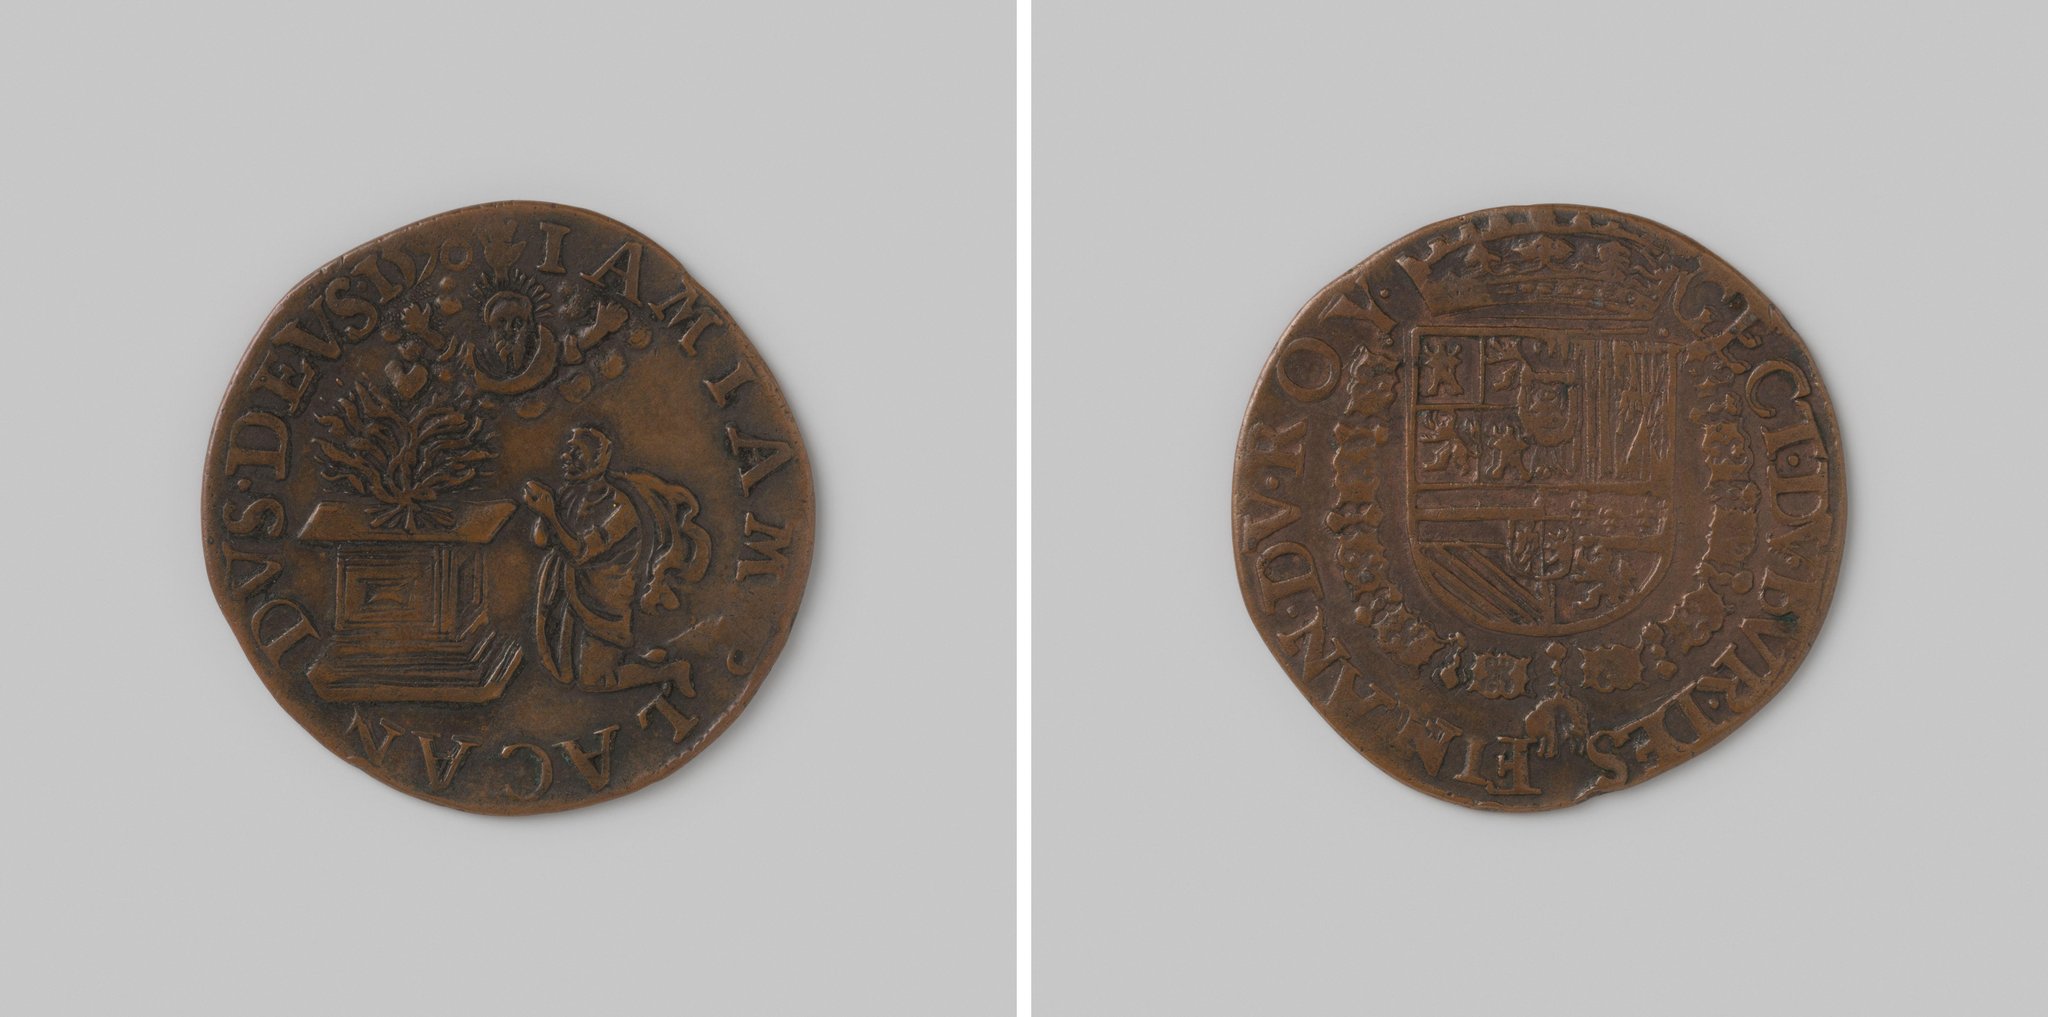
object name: jeton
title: Rekenpenning uit Antwerpen voor het Bureau des Konings op de ongunstige tijden 1590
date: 1590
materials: copper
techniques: striking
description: Koperen penning, op de voorzijde een man biddend voor een brandend altaar, met omschrift, op de keerzijde het gekroonde wapenschild van Spanje omhangen met de keten van het gulden vlies, met omschrift.